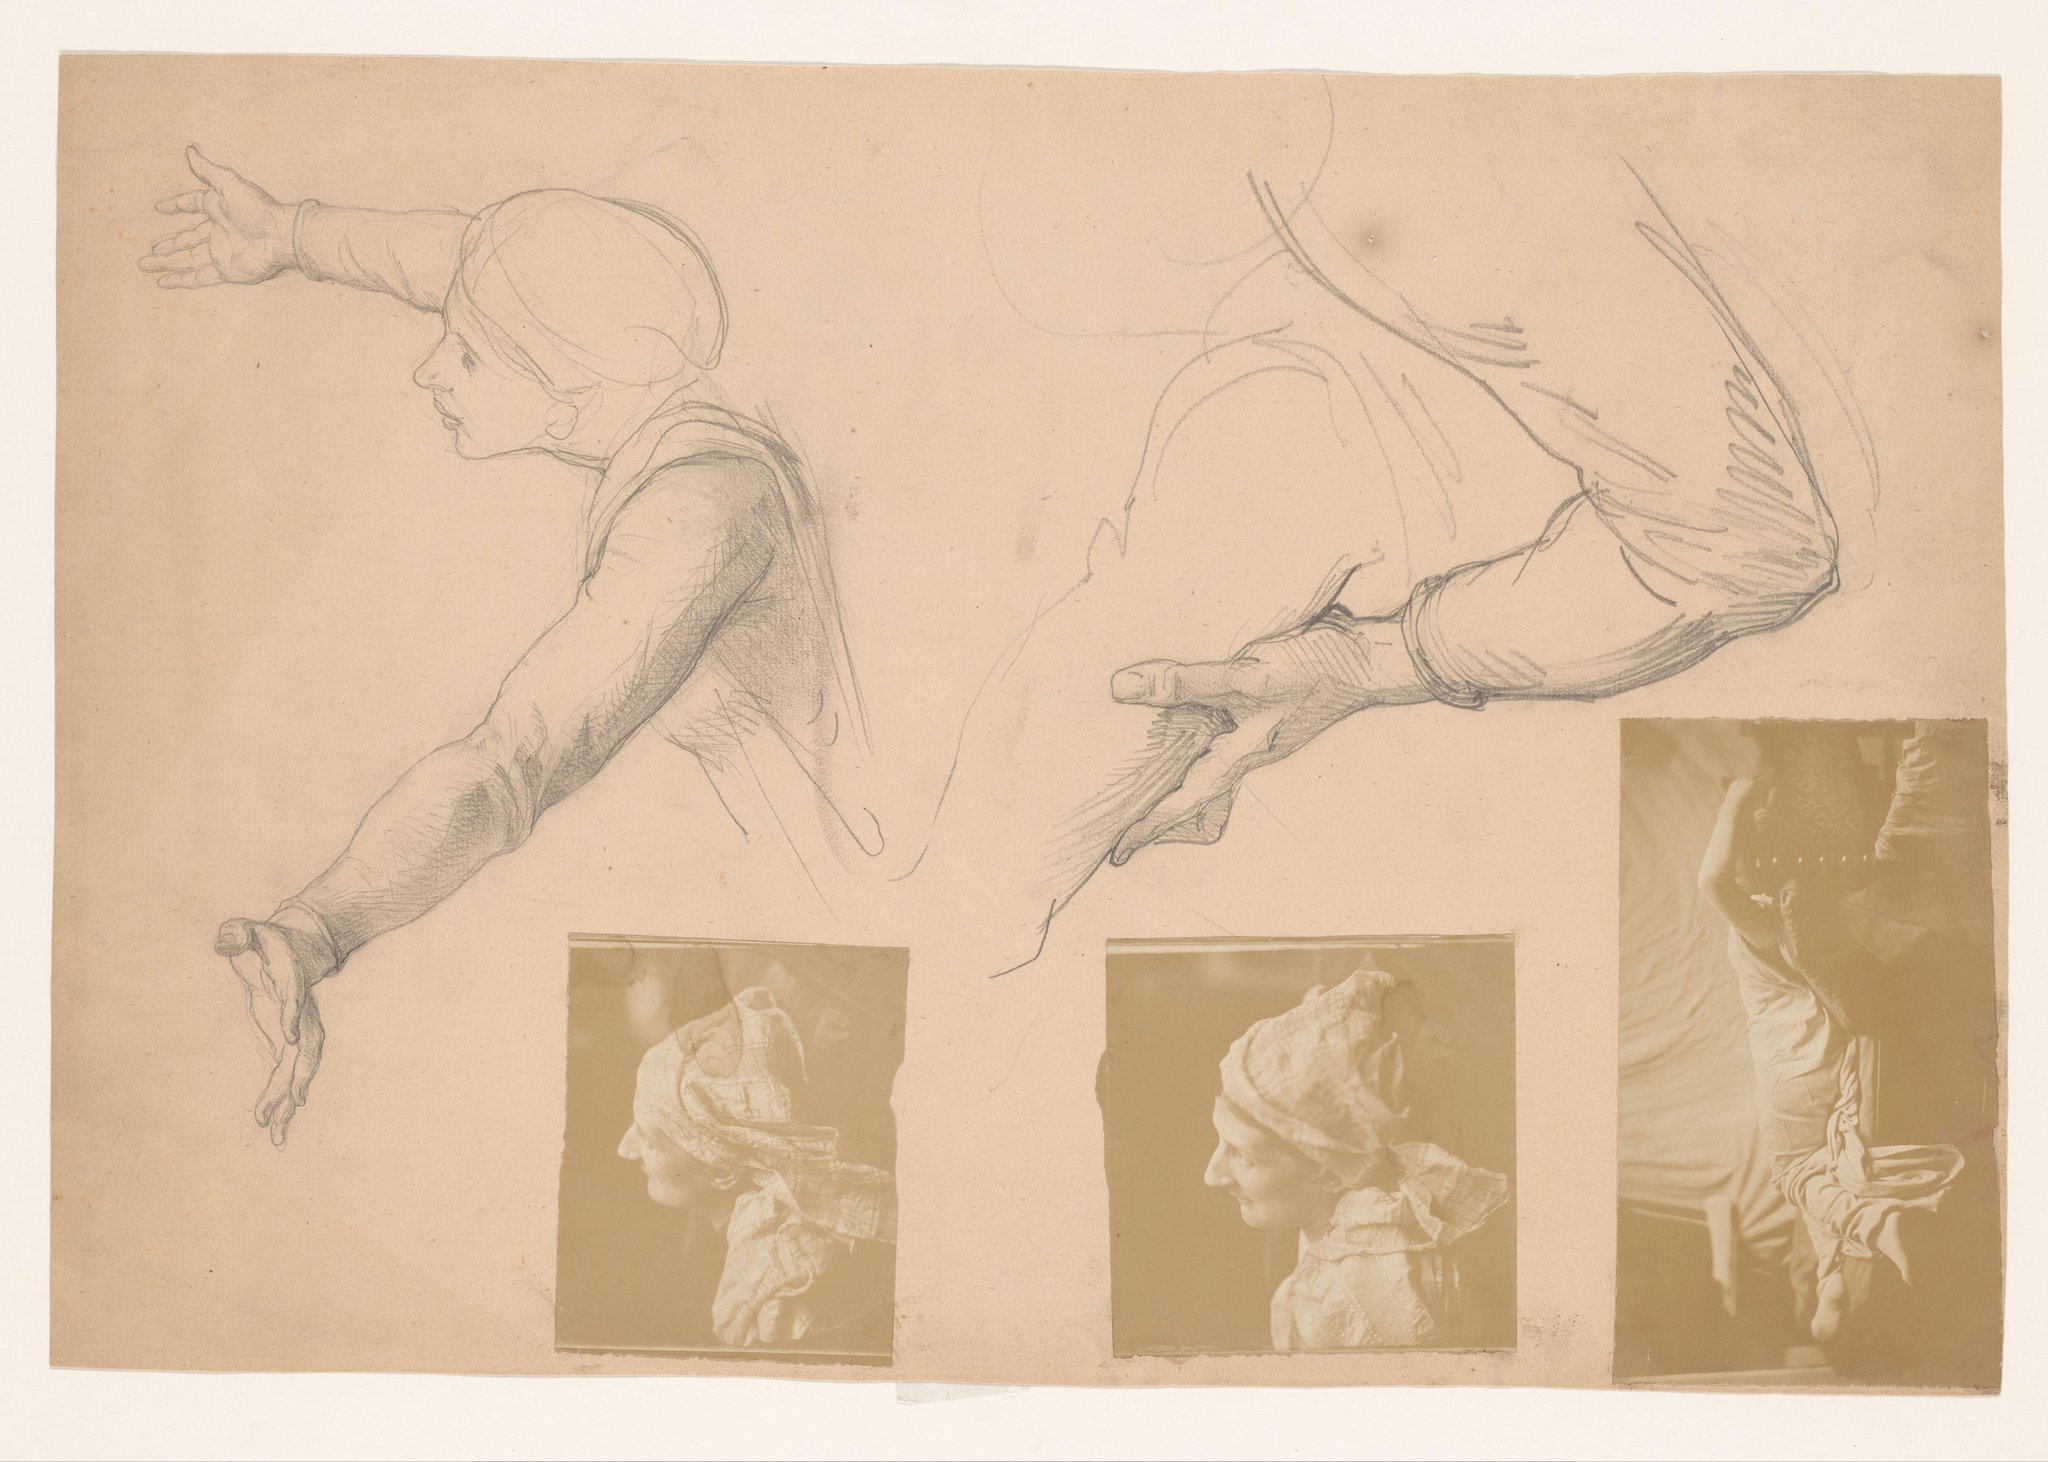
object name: drawing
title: Ontwerptekening met daarop gemonteerd drie albuminedrukken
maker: félix joseph barrias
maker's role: draughtsman, painter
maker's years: 1822-1907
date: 1875-1877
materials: paper, photographic support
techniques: albumen print, drawing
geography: paris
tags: sainte-trinité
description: Ontwerptekening voor fresco St. Trinite in Parijs, met daarop gemonteerd drie foto's.